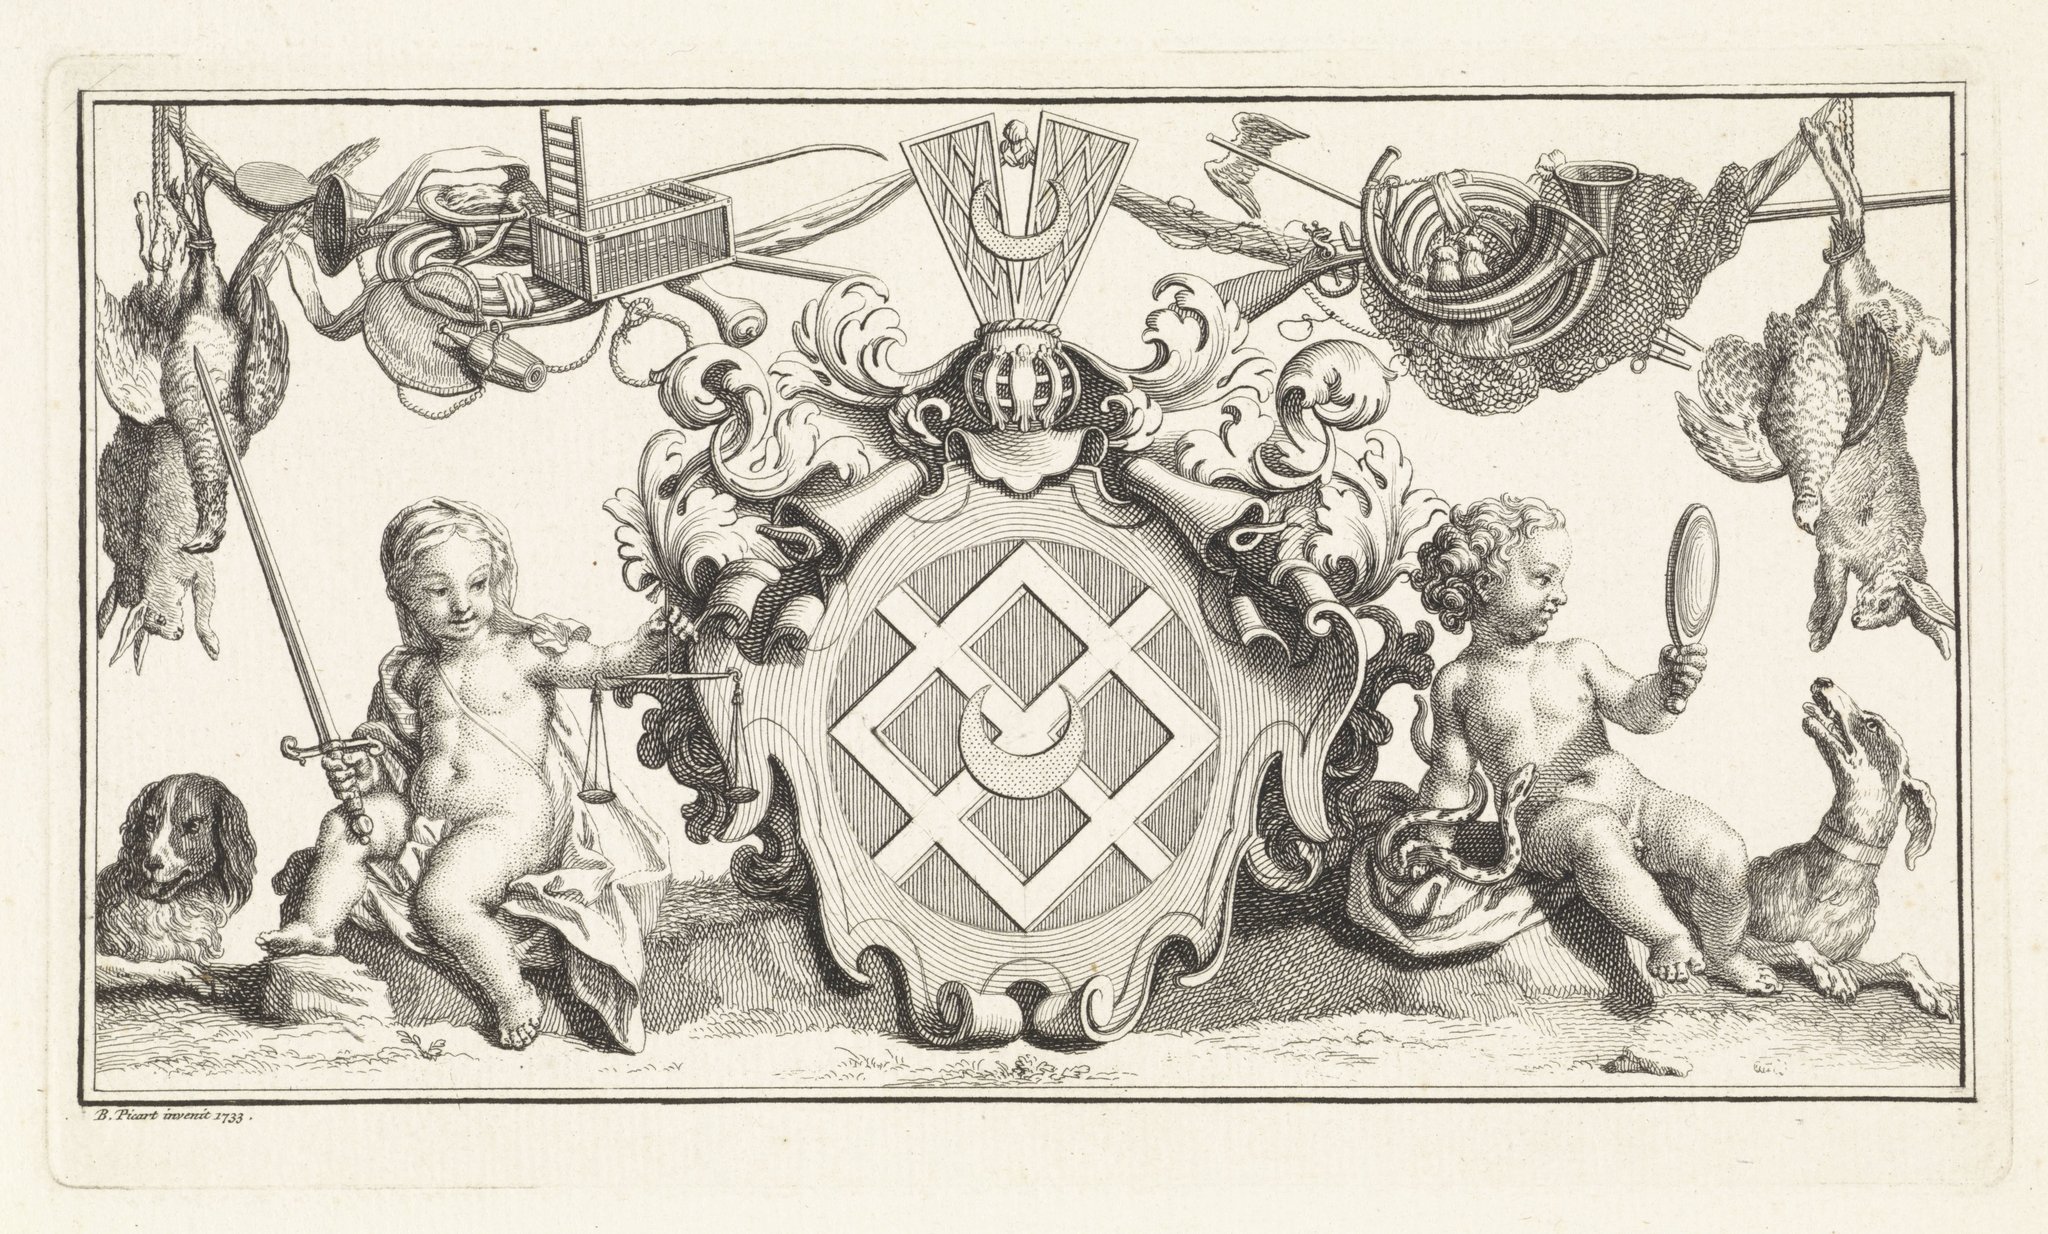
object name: print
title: Wapenschild omgeven door jachttrofeeën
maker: bernard picart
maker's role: draughtsman, print maker, publisher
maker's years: 1673-1733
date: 1733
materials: paper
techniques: engraving, etching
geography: amsterdam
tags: coat of arms (as symbol of the state, etc.), ornaments ~ art, justice; 'forza alla giustitia sottoposta', 'giustitia', 'giustitia retta', 'giustitia rigorosa', 'impietà e violenza soggetta alla giustitia' (ripa), precaution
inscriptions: collector's mark: Lugt 240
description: Wapenschild, geflankeerd door de personificaties van rechtvaardigheid en voorzichtigheid, omgeven door jachttrofeeën.